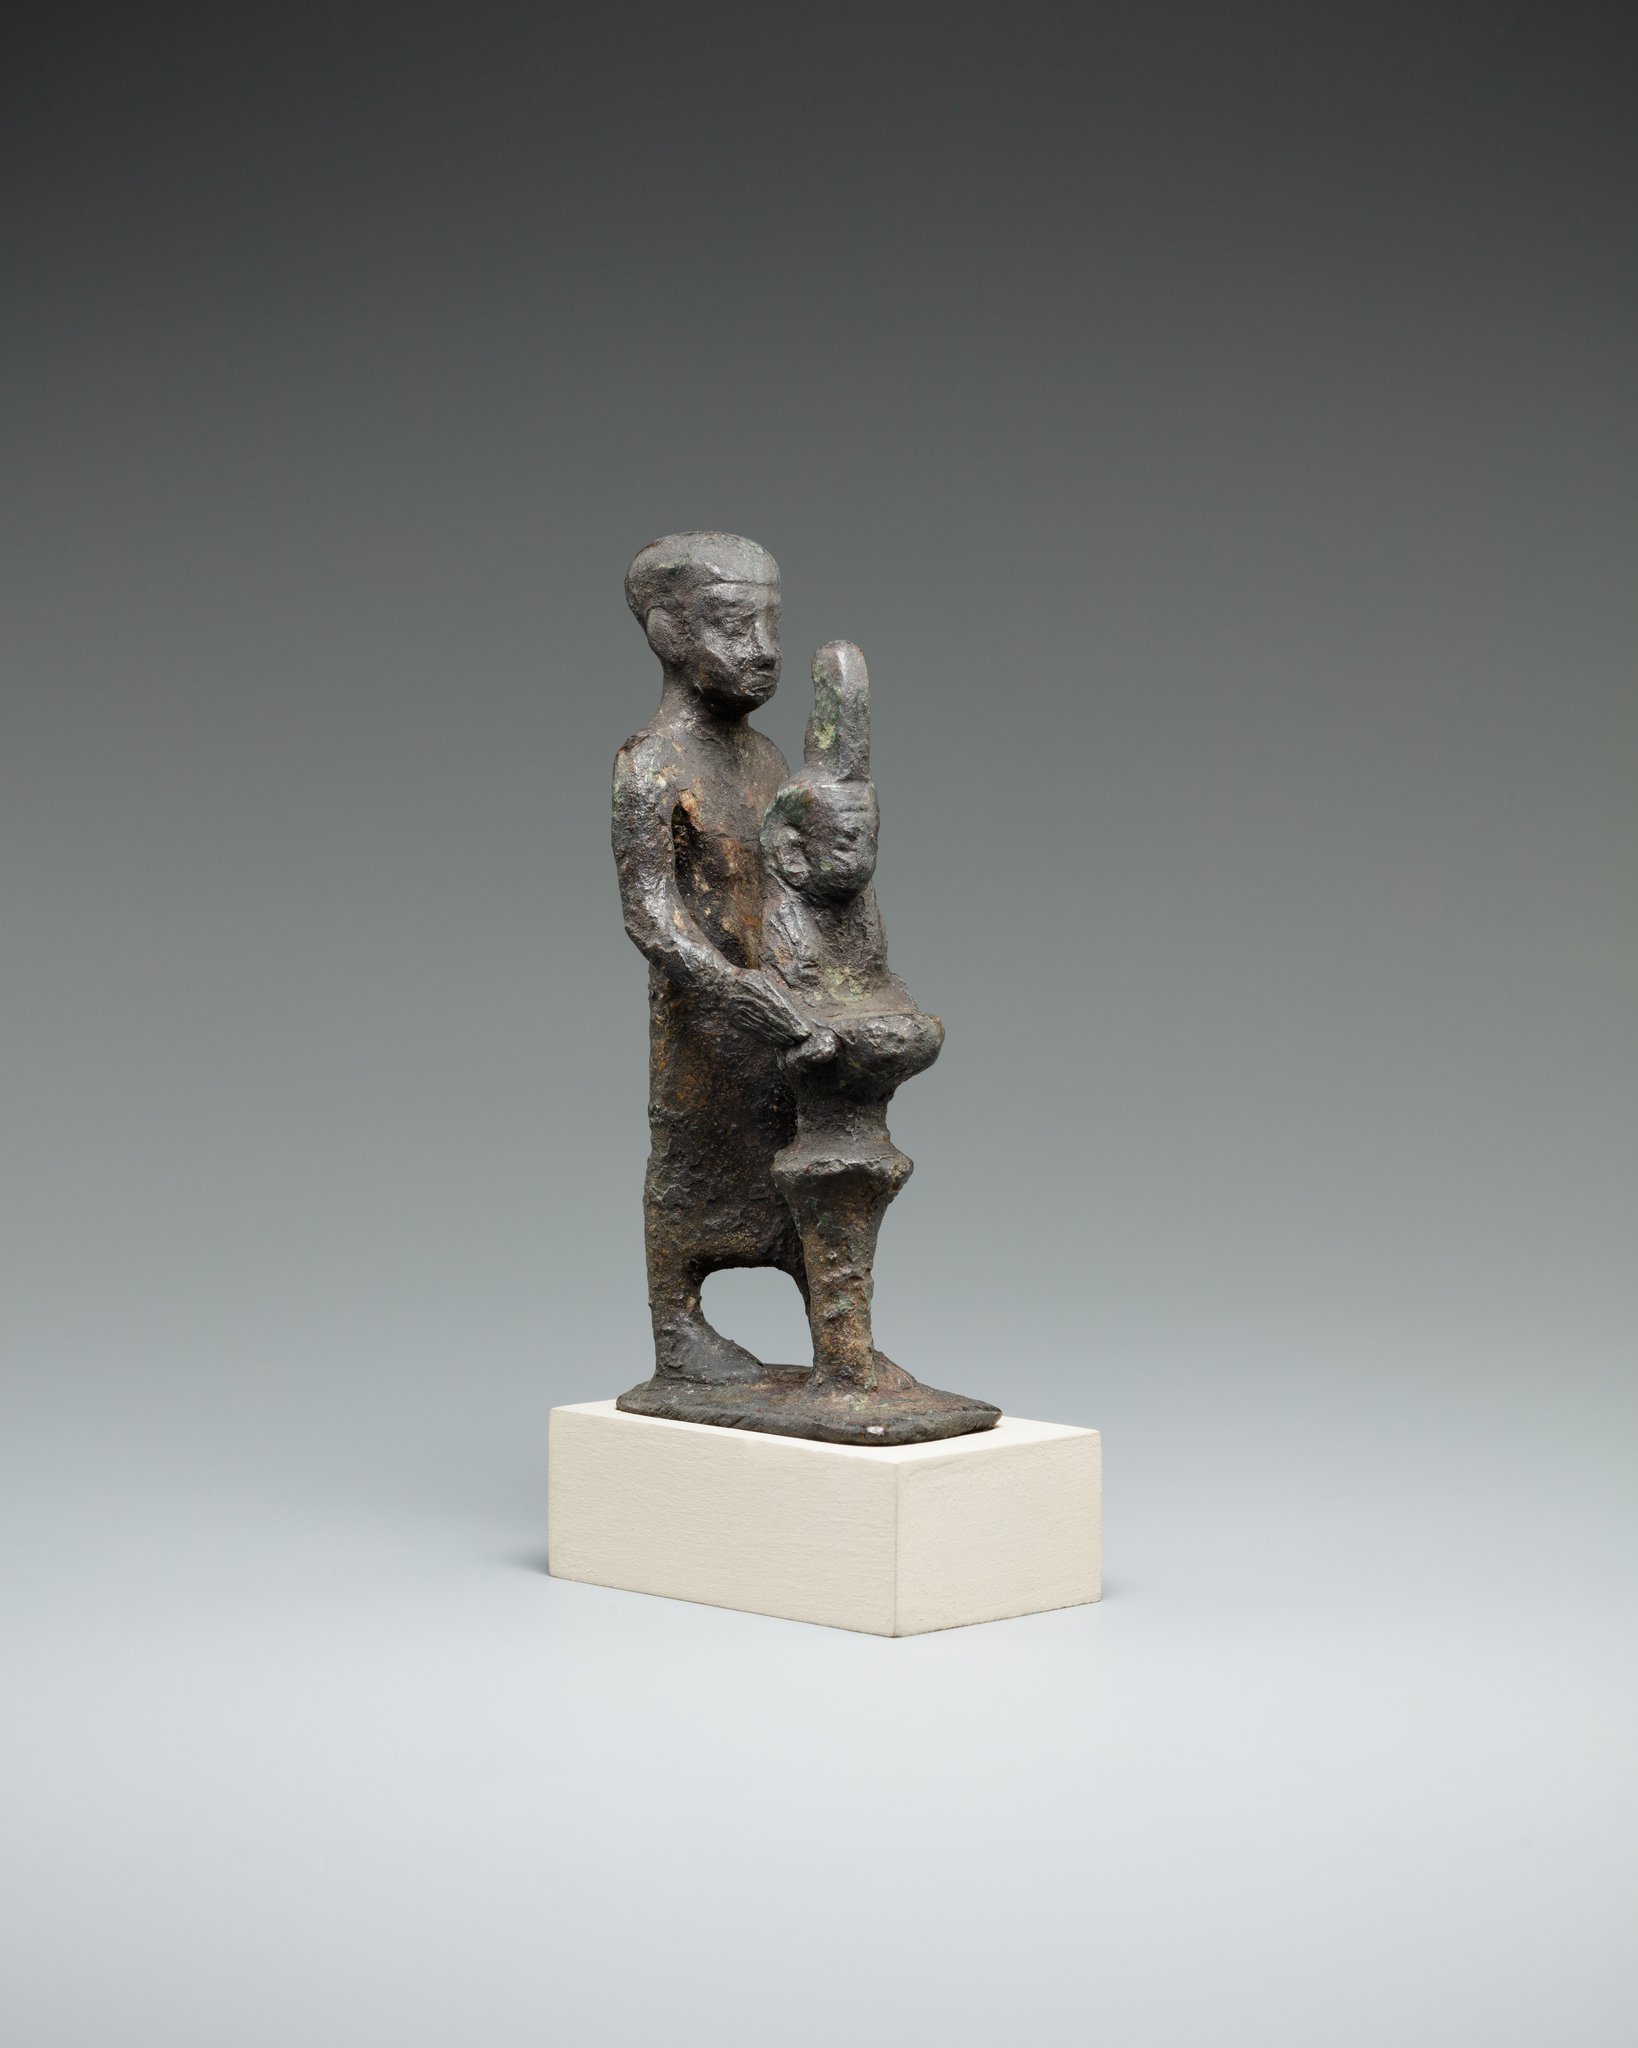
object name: figurine, man, ma'at standard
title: Individual holding a Maat bust on a stand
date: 664-630 BCE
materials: alloy, bronze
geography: egypt